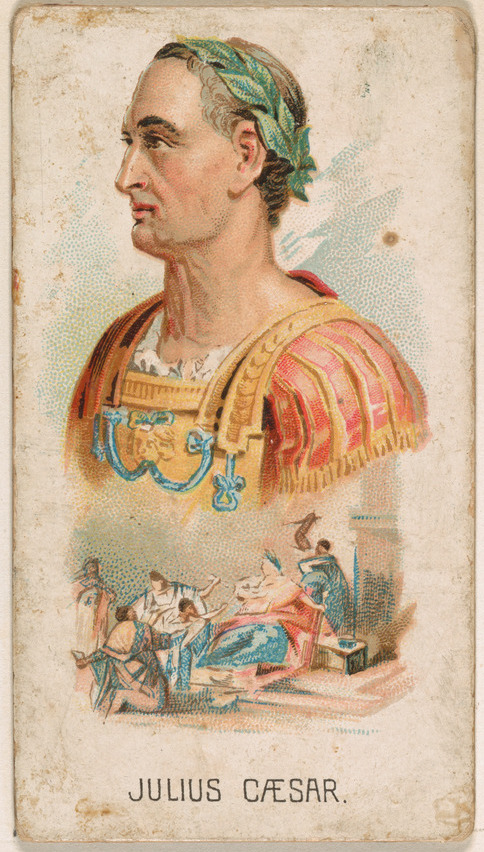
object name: print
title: Julius Caesar, from Leaders series (N222) issued by Kinney Bros.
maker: kinney brothers tobacco company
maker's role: publisher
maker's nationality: american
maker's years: 1869-2011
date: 1888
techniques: color lithograph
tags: julius caesar,profiles